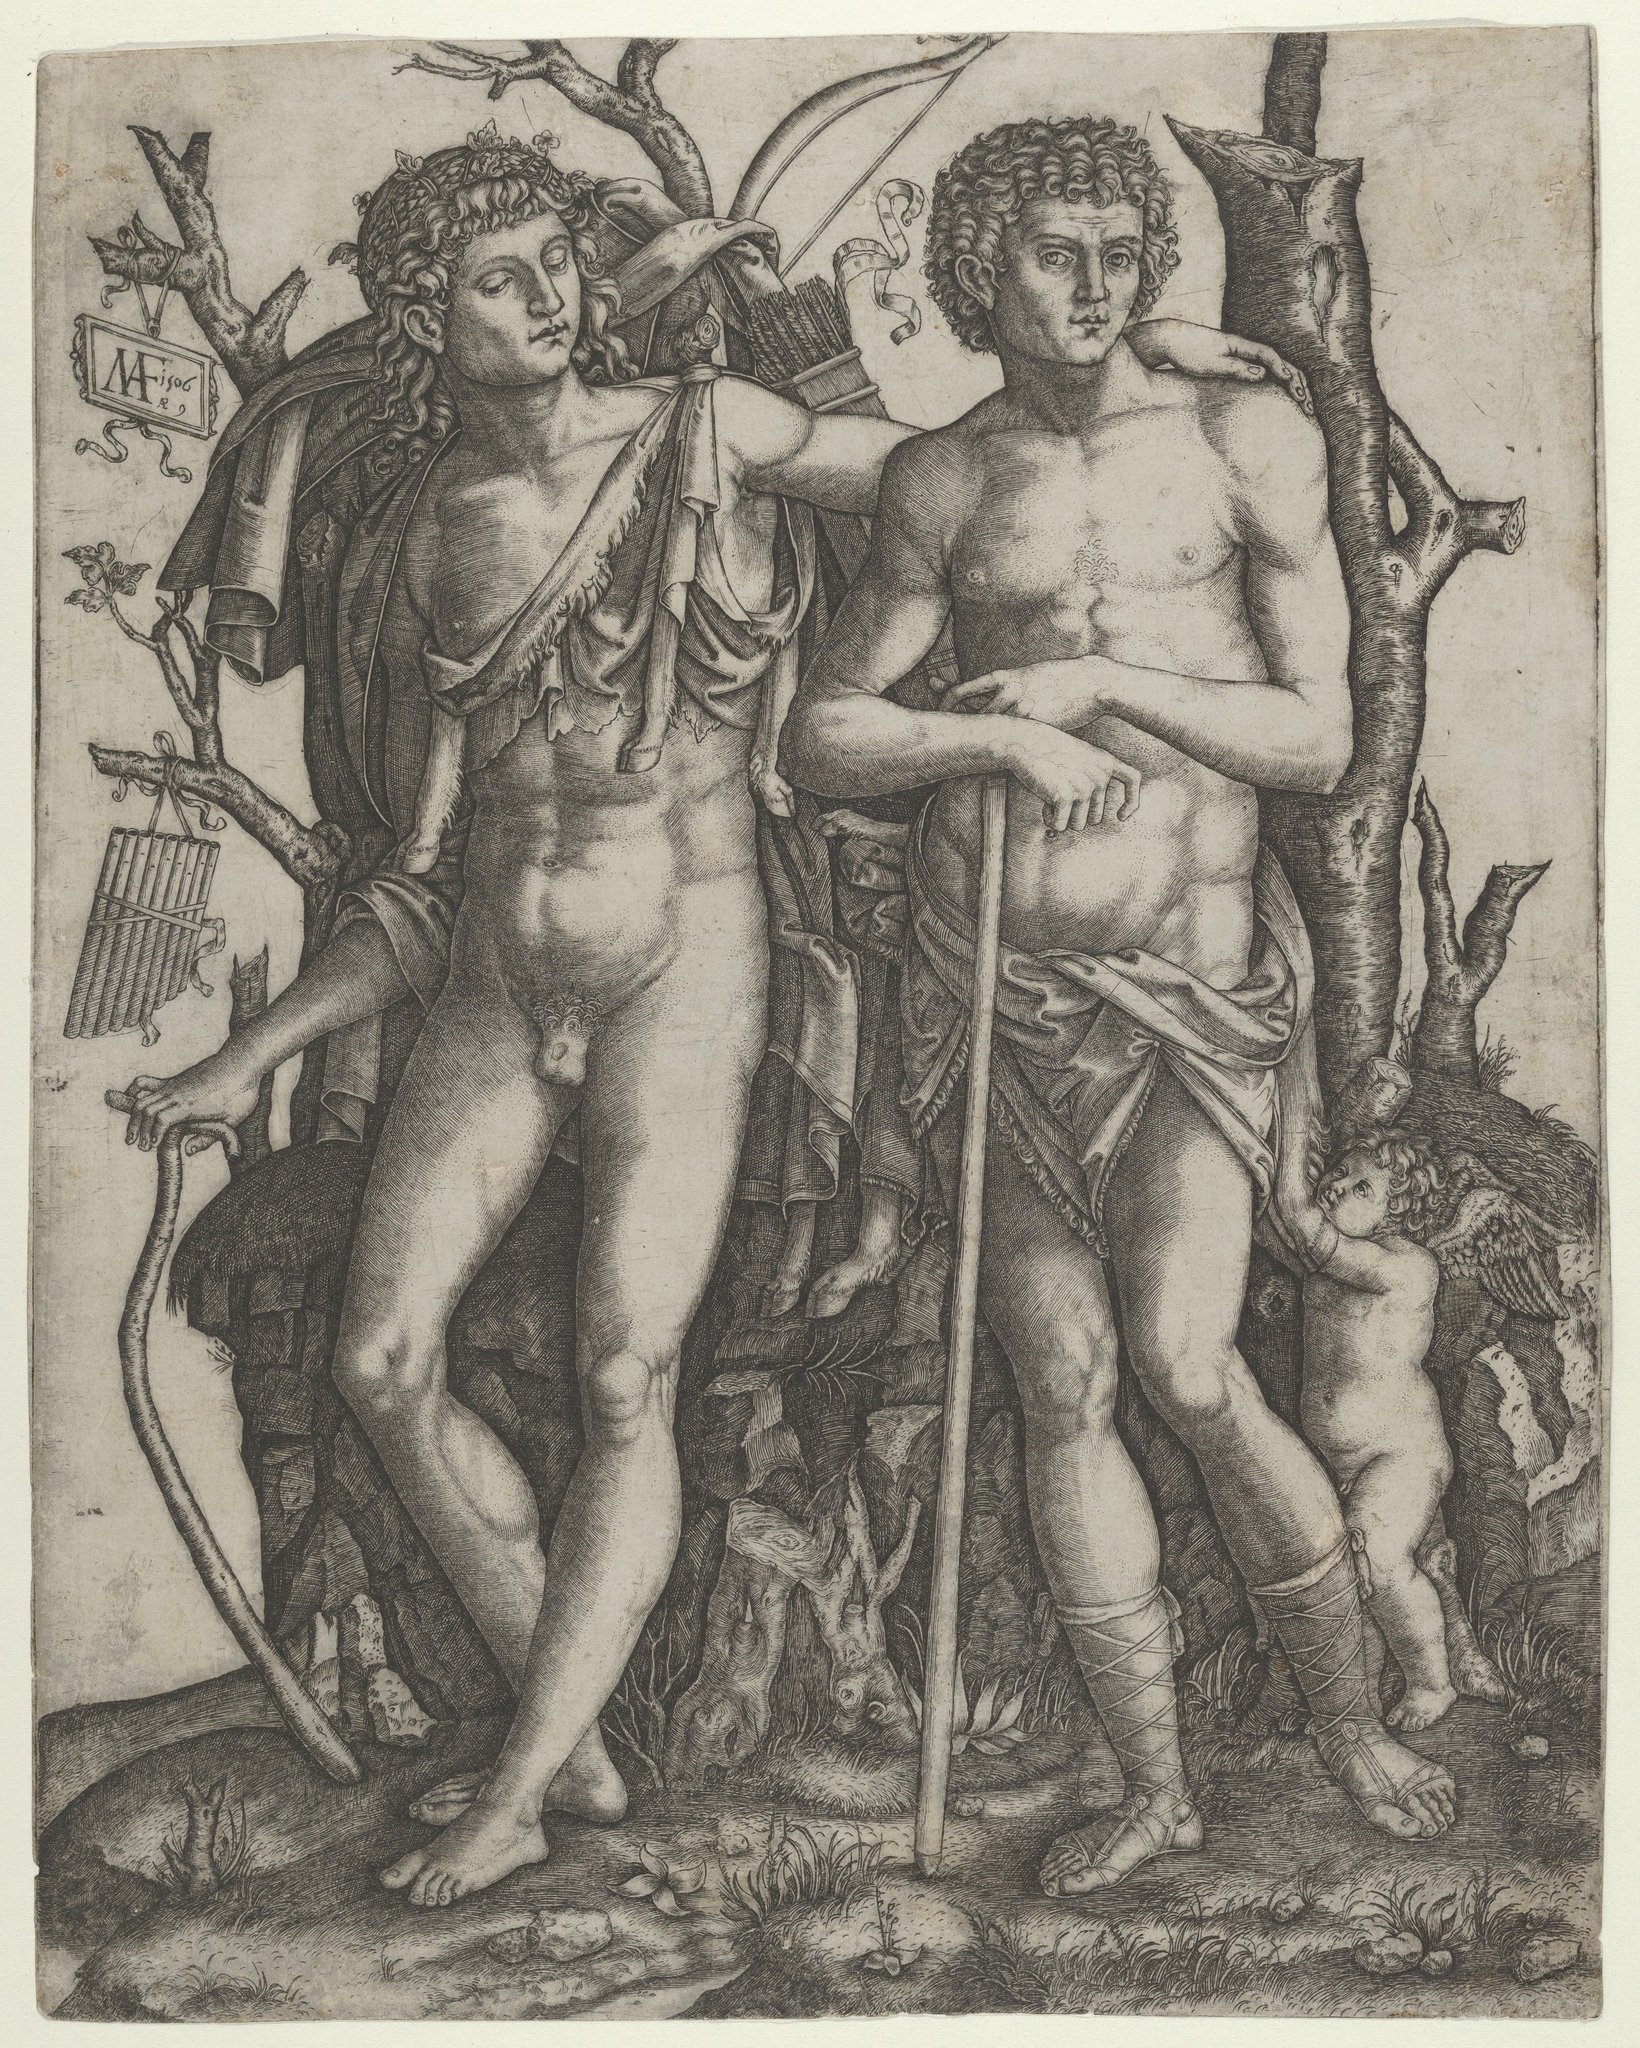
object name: print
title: Apollo standing at the left, his hand resting on the shoulder of Hyacinthus, Cupid in the lower right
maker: marcantonio raimondi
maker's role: artist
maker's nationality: italian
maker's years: 1475-1534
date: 1506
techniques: engraving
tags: male nudes,cupid,apollo